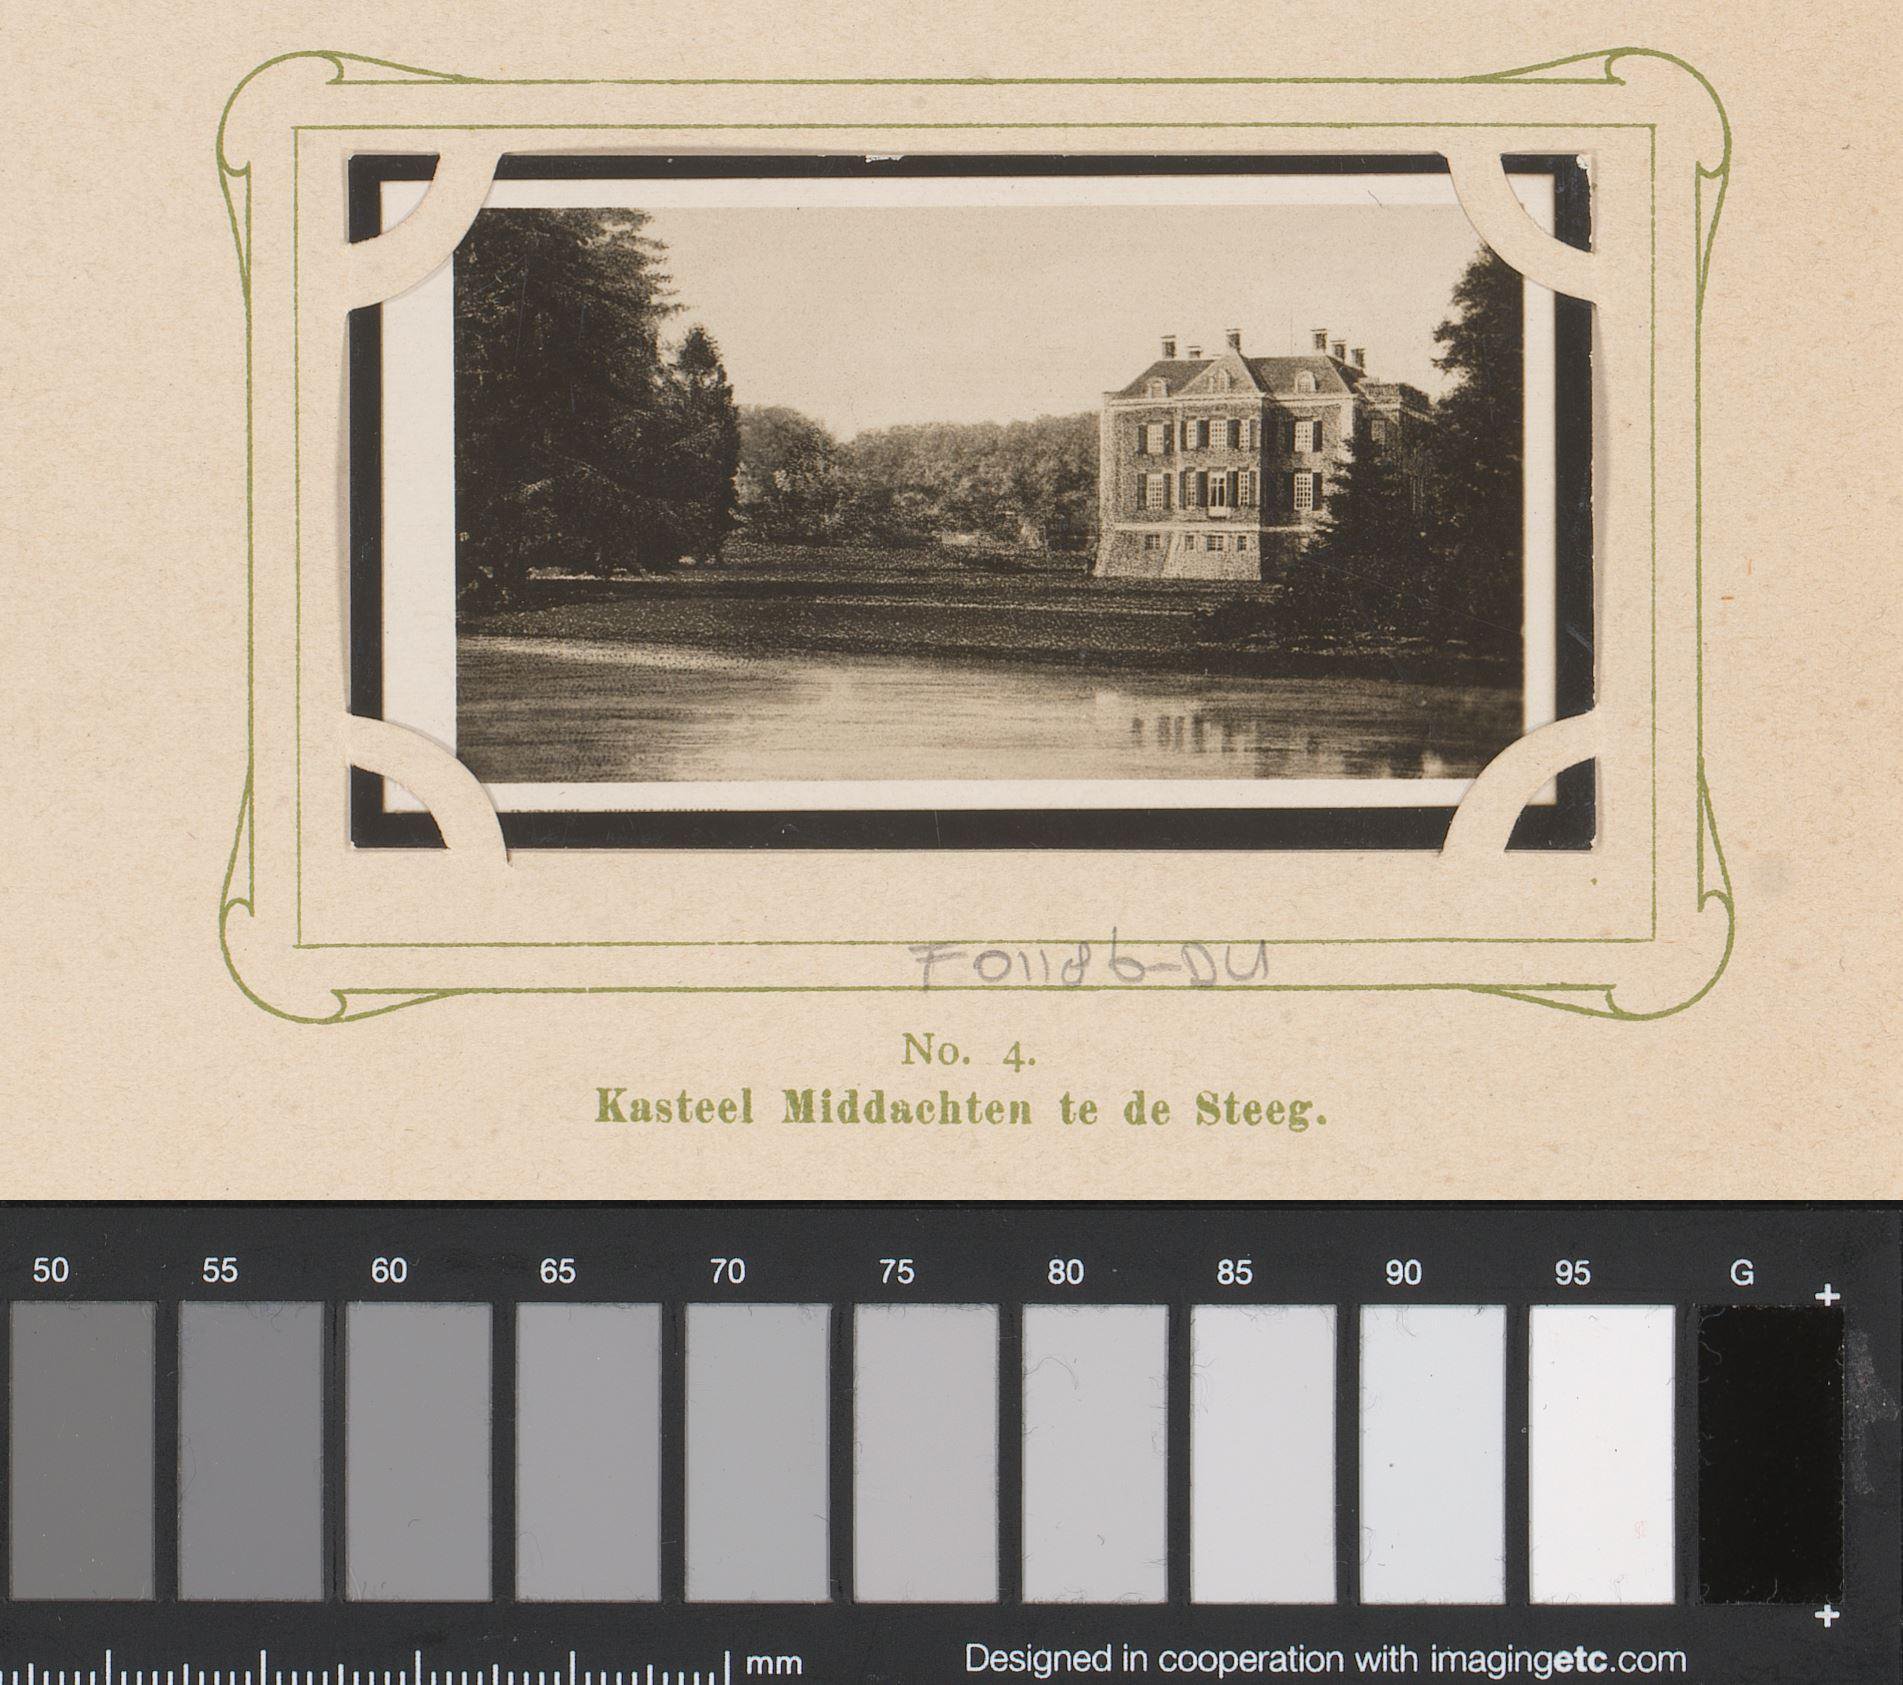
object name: album leaf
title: Gezicht op Kasteel Middachten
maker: Anonymous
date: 1904-1905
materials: photographic support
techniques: gelatin silver print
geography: de steeg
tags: landscape with tower or castle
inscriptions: inscription: ‘No. 4./ Kasteel Middachten te de Steeg.’